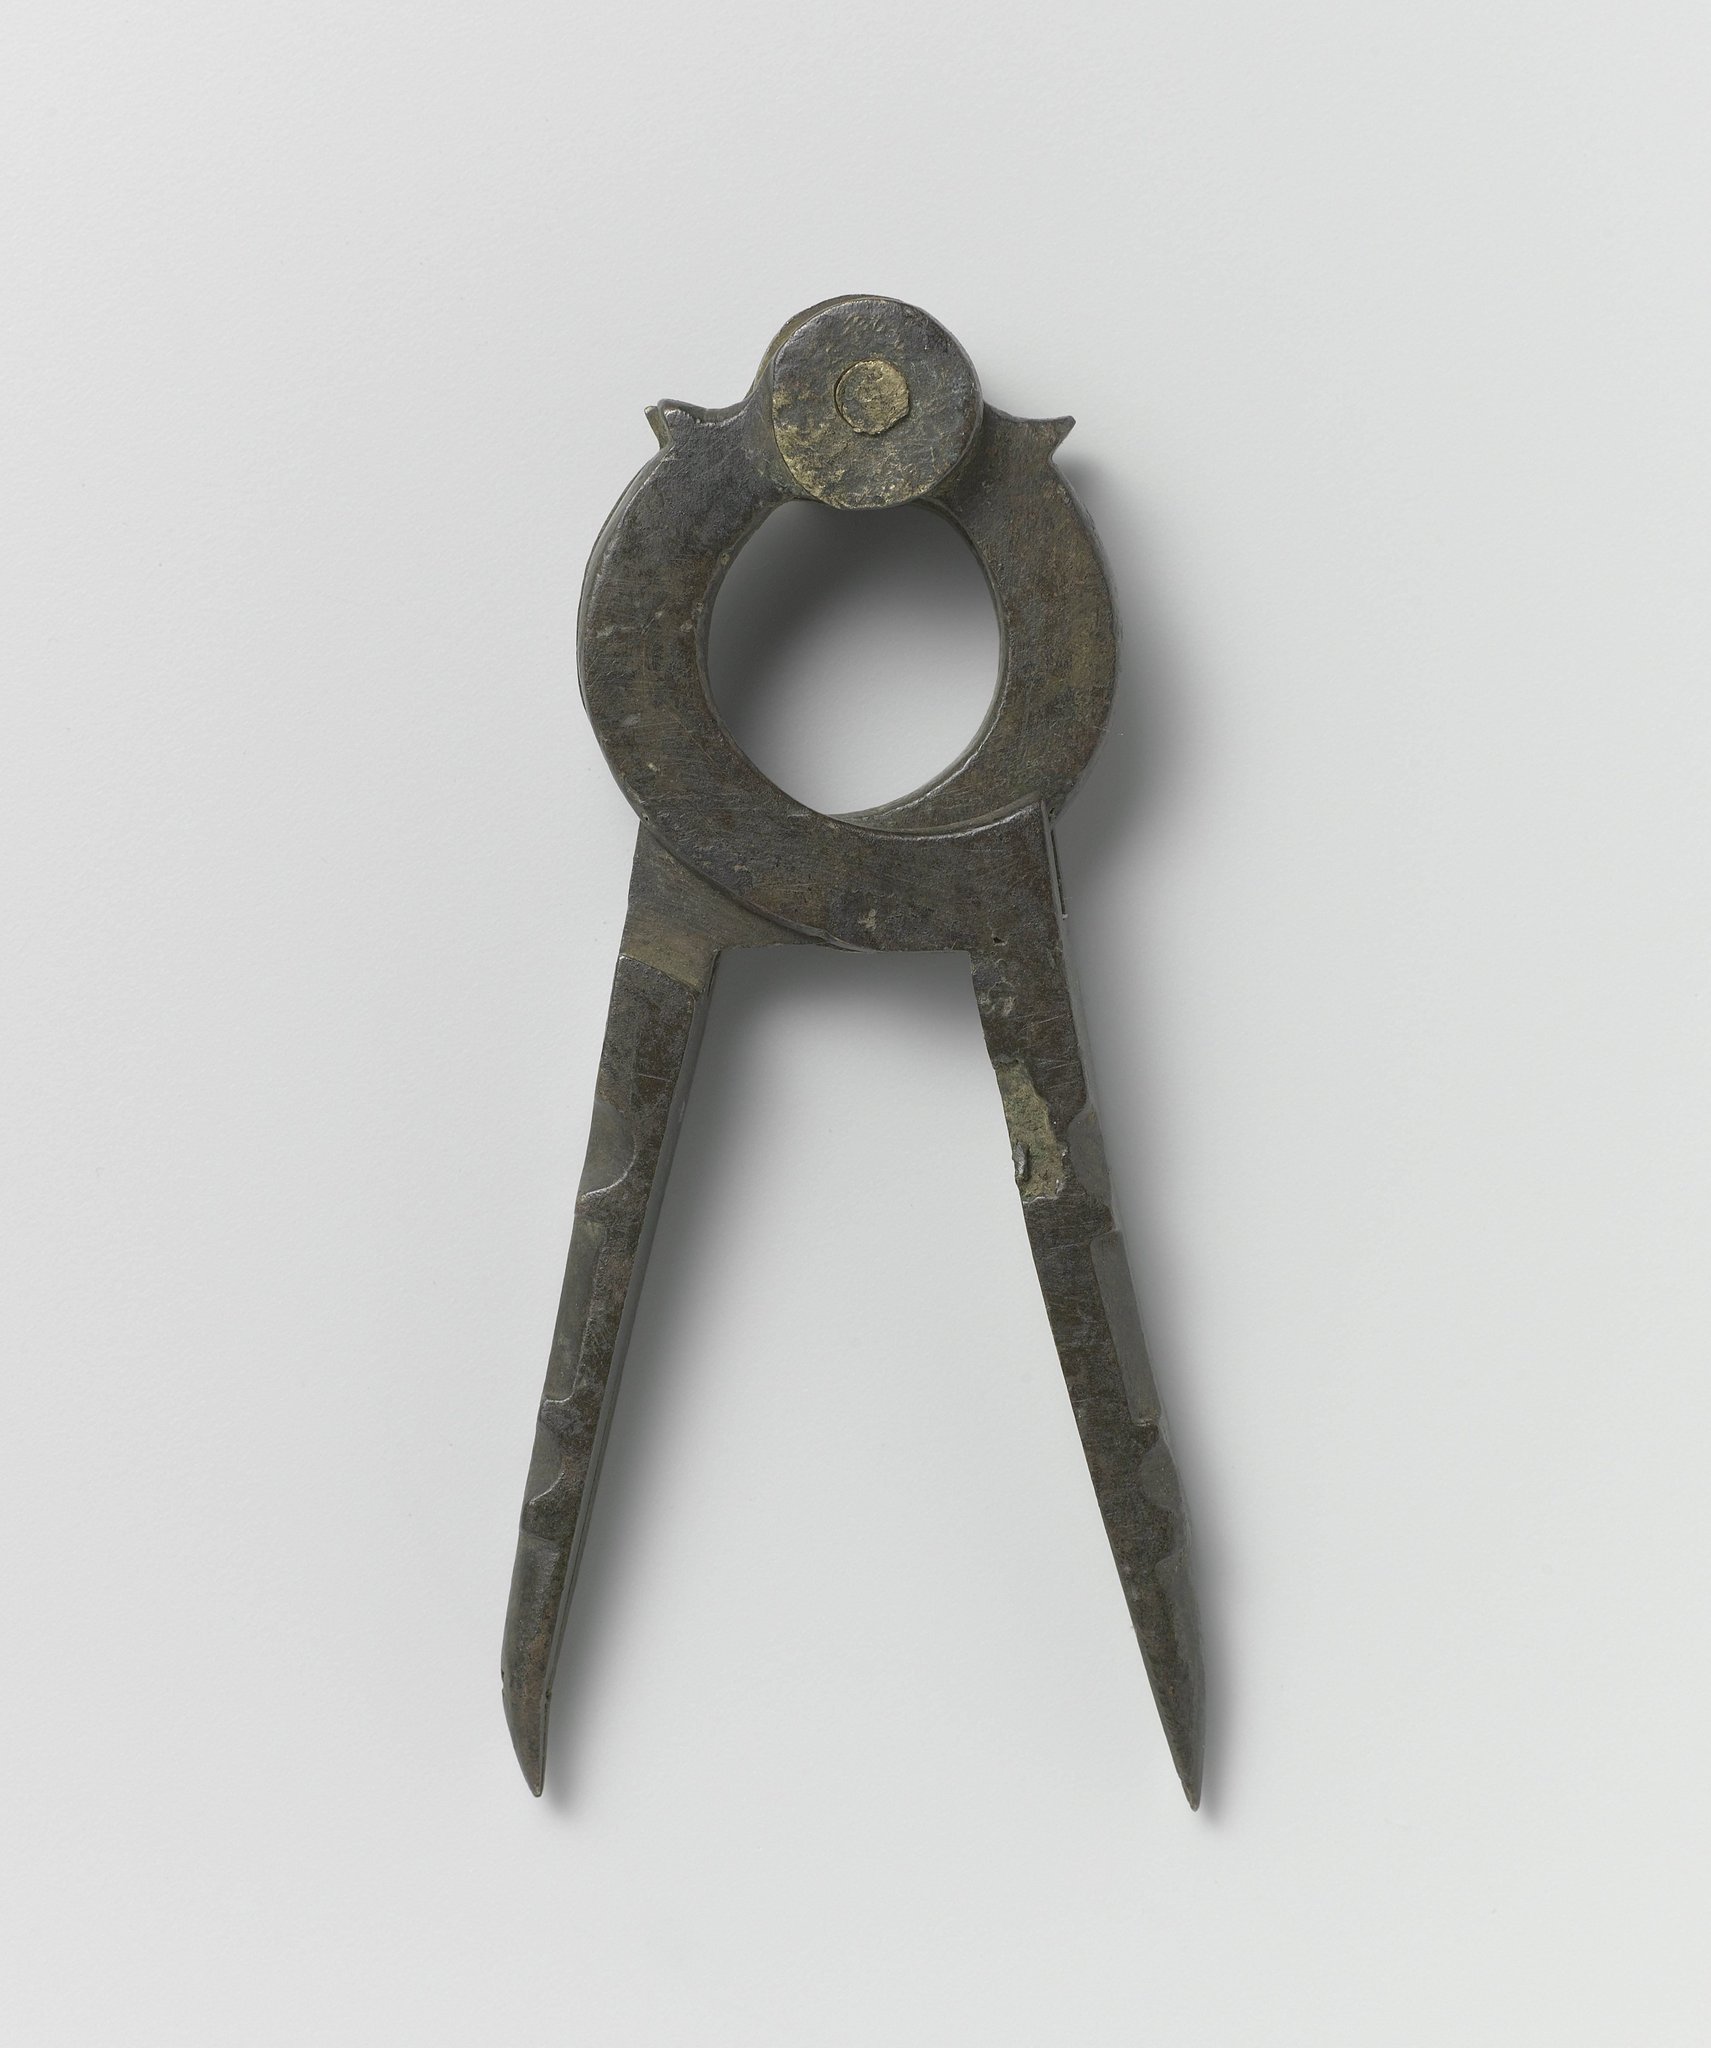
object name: compass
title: Navigation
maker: Anonymous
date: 1590-1596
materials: brass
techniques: casting, filing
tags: willem barendsz., amsterdam, jacob van heemskerck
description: To determine the ship’s position and chart its course, the captain had an entire arsenal of instruments at his disposal. Among the items found on Nova Zembla are an astrolabium catholicum (universal astrolabe), a fragment of a copper sounding line, a cross staff, a sextant and a chart compass.